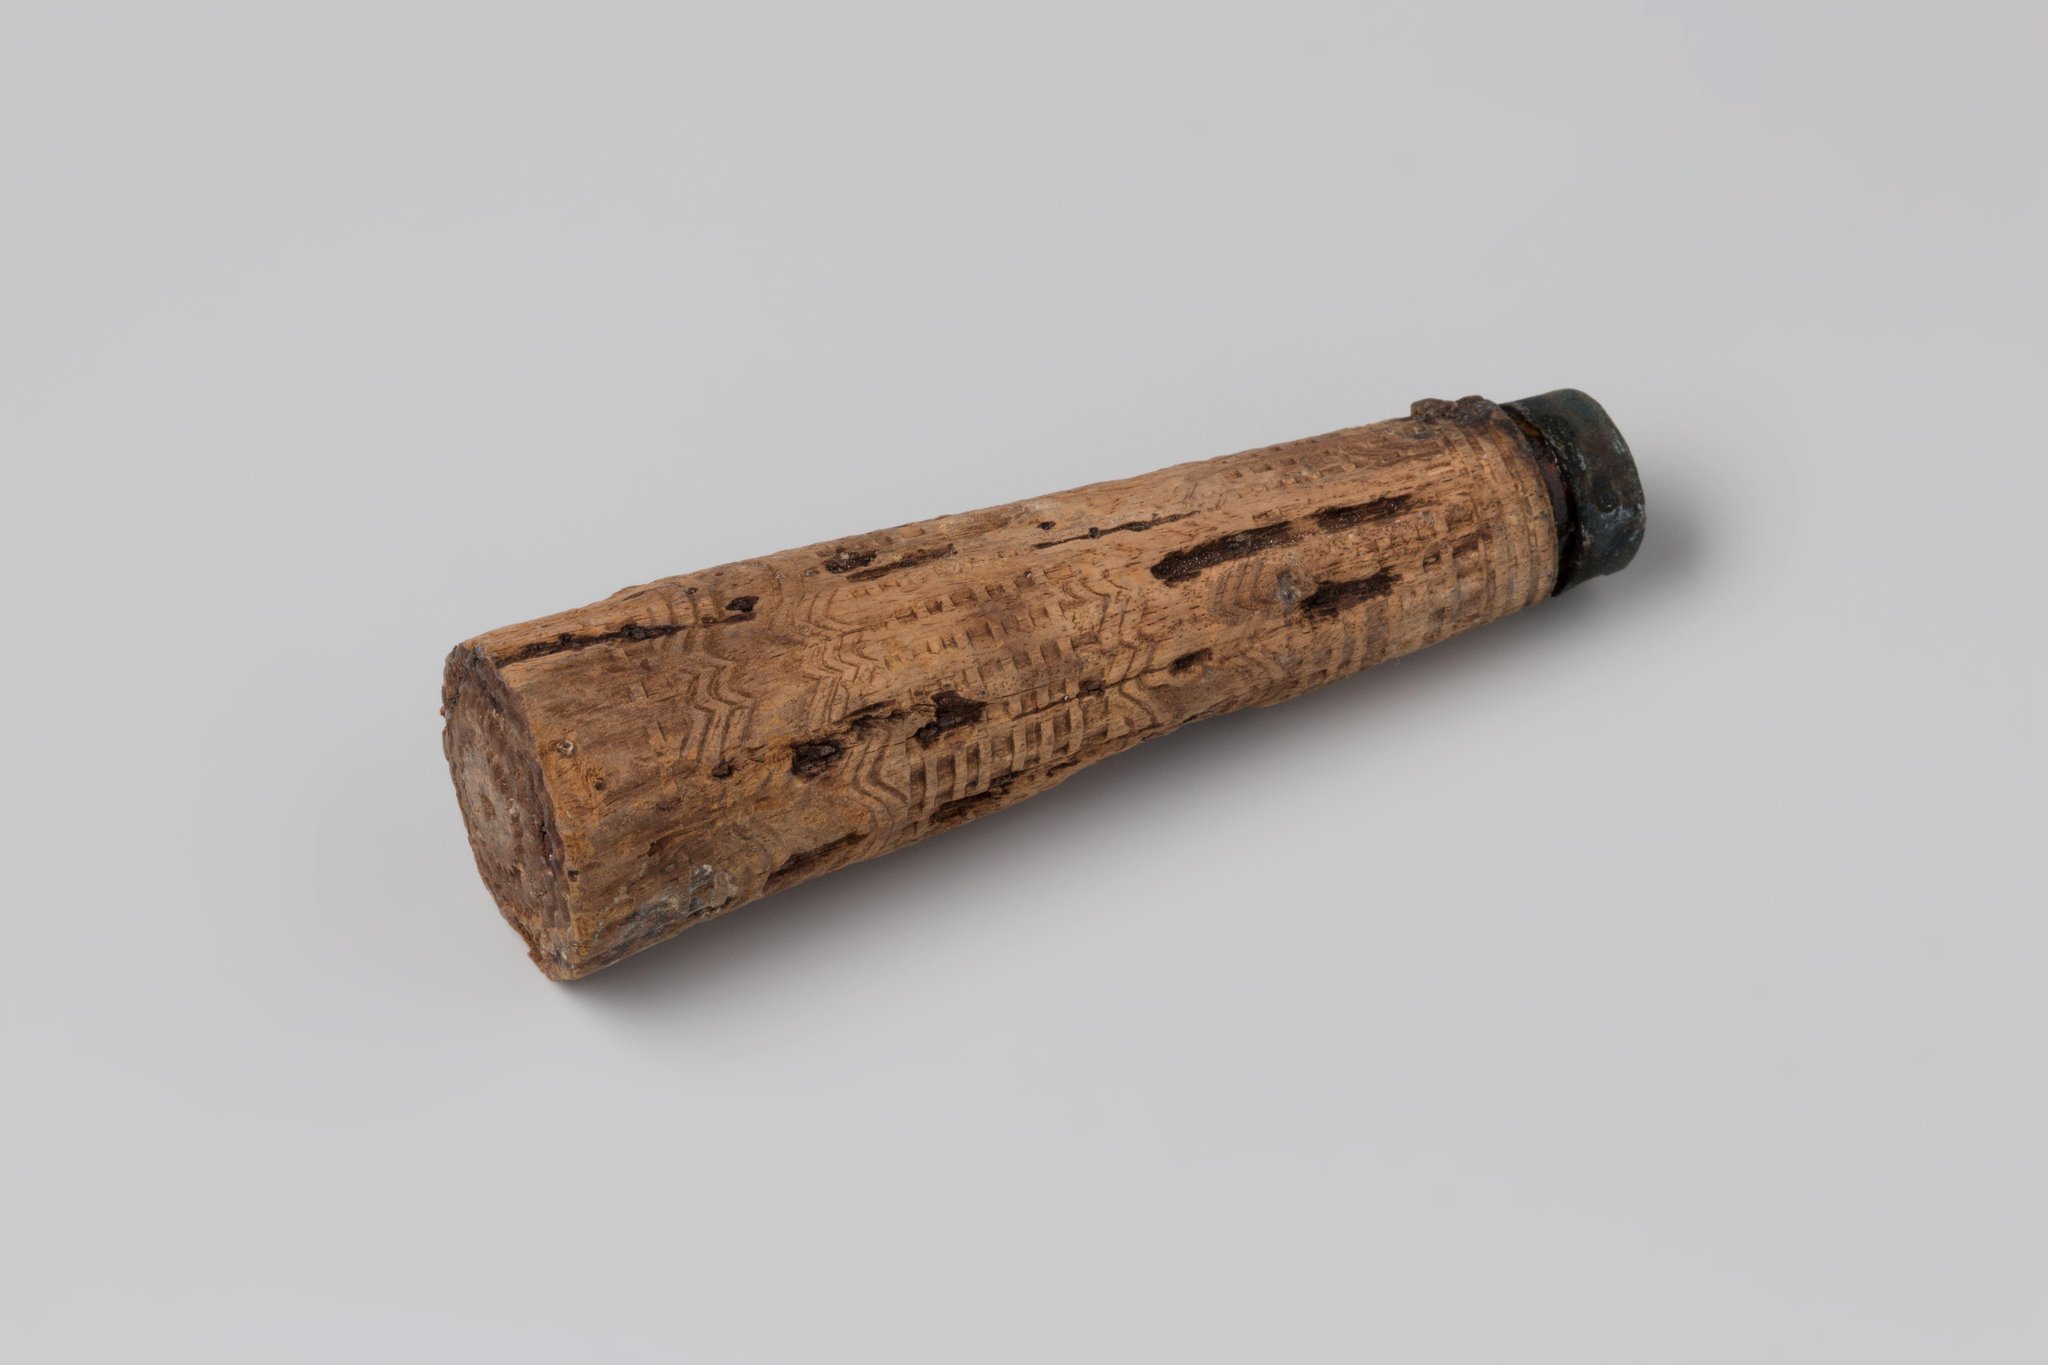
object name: knife handle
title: Messenheft uit het wrak van de Oost-Indiëvaarder Hollandia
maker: Anonymous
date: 1700-1743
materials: copper, wood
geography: netherlands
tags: verenigde oostindische compagnie, hollandia (schip), annet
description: Knife, handle, cylindrical: tapering; id. NG 1979-403H, ferrule, id. NG 1980-27H426.